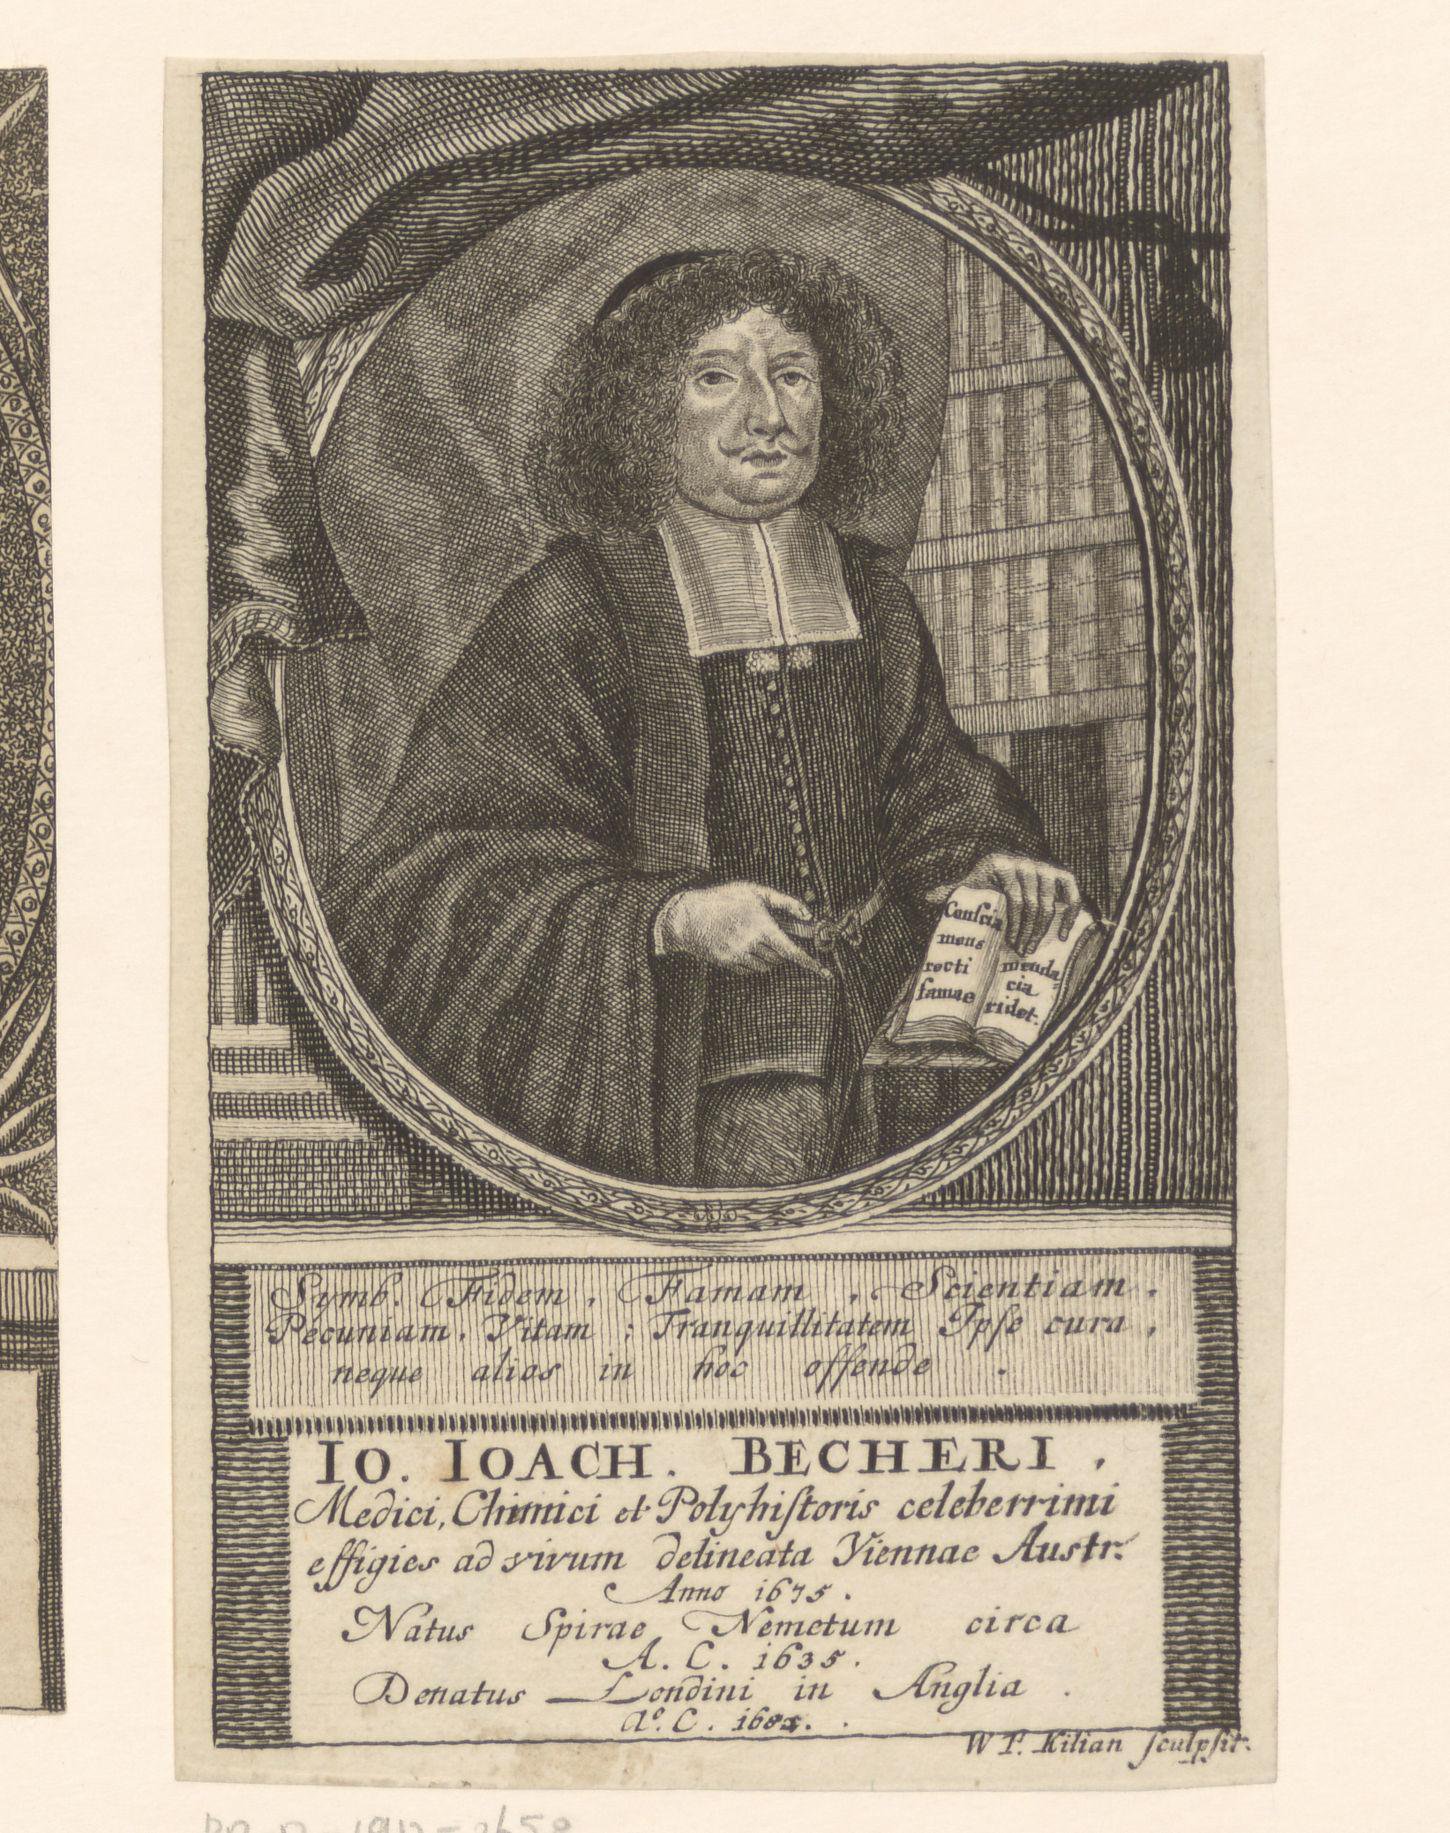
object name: print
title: Portret van Johann Joachim Becher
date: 1682-1732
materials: paper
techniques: engraving, etching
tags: london, chemistry (+ portrait of scholar, scientist), historical persons, physician, doctor (+ portrait of scholar, scientist)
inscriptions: collector's mark: Lugt 2228